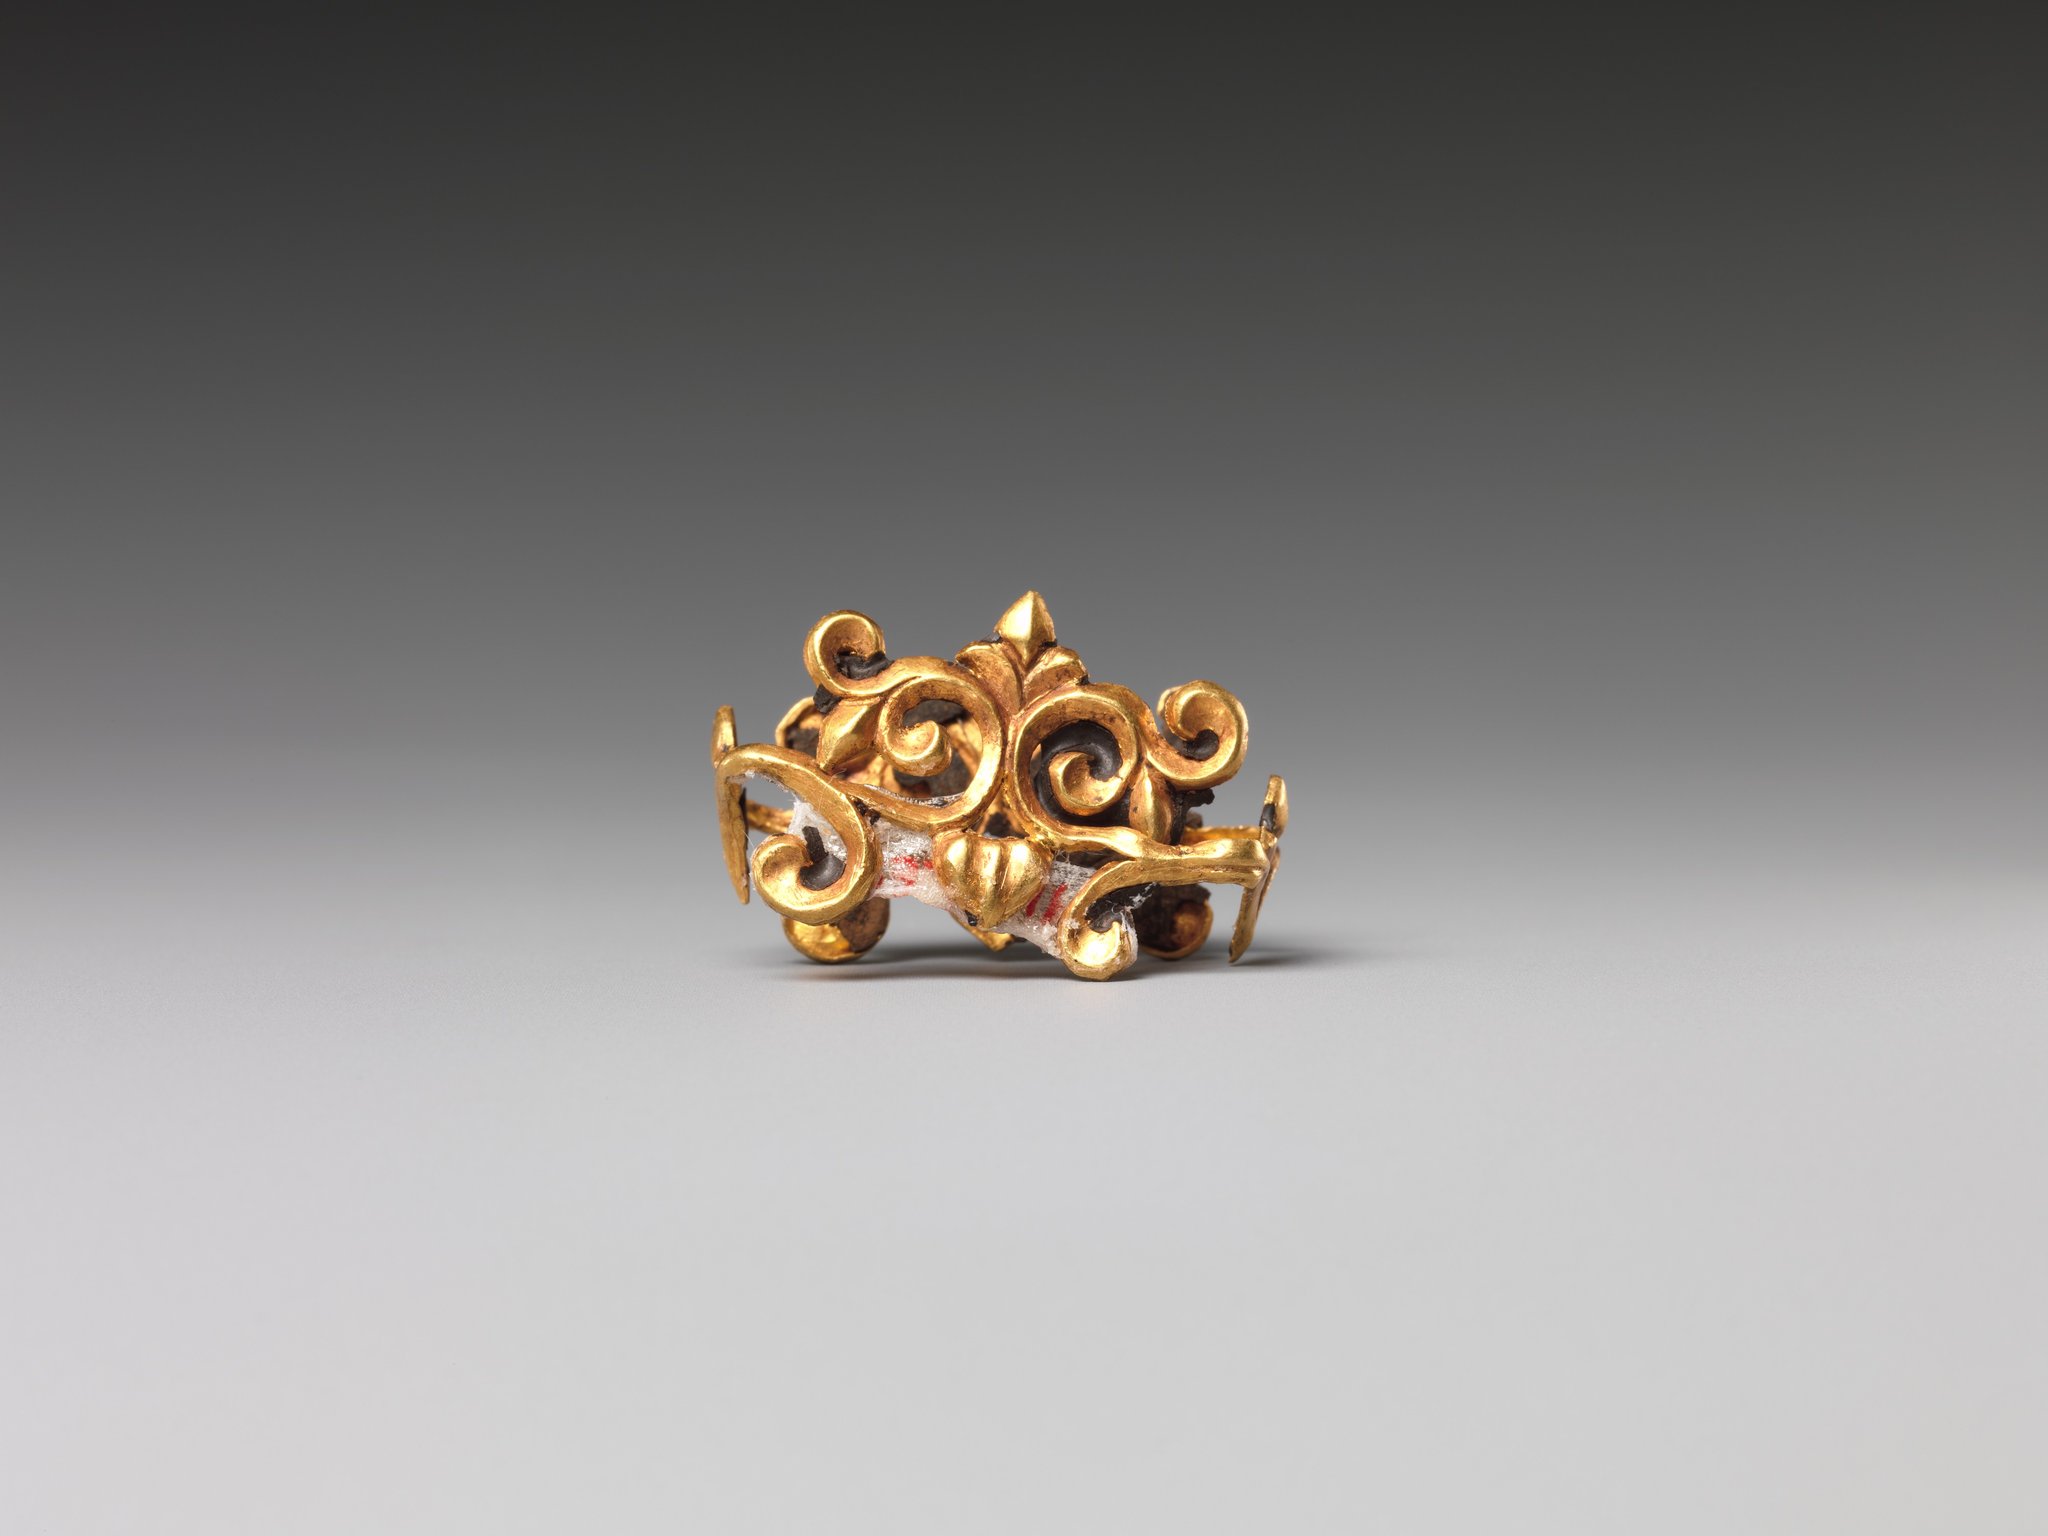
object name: fitting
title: Openwork Fitting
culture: chinese or central asian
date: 601-900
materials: gold